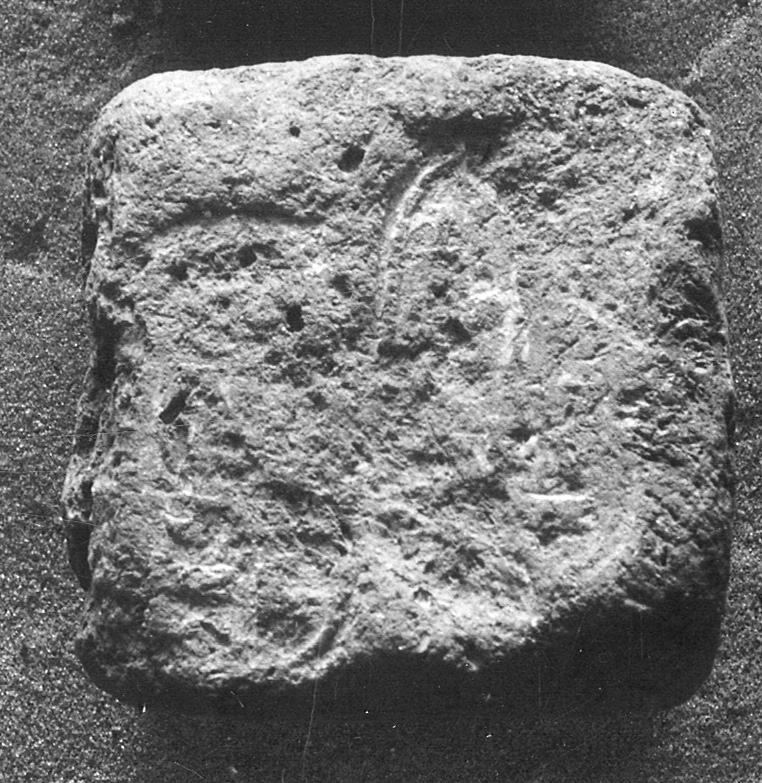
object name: cone, oval impression, wershu, henet, square cone, chief servant of amun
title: Funerary Cone of Wershu and His Wife Henet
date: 1550-1295 BCE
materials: pottery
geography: egypt